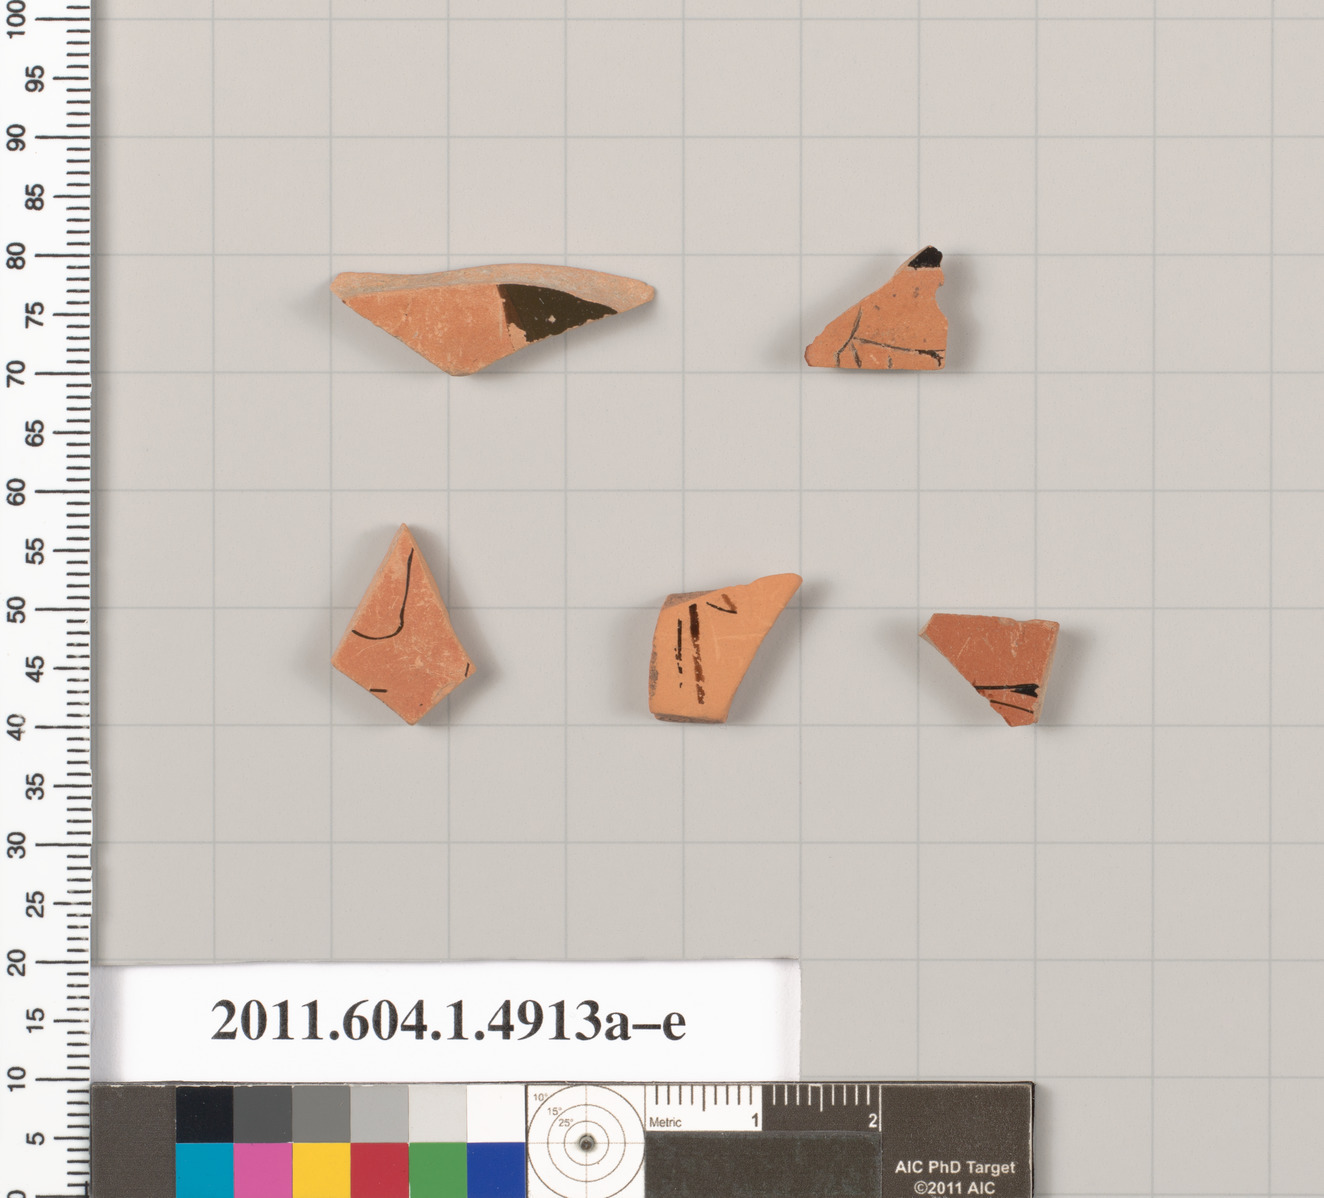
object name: kylix fragment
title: Terracotta fragments of kylikes (drinking cups)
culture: greek, attic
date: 600-401 BCE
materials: terracotta